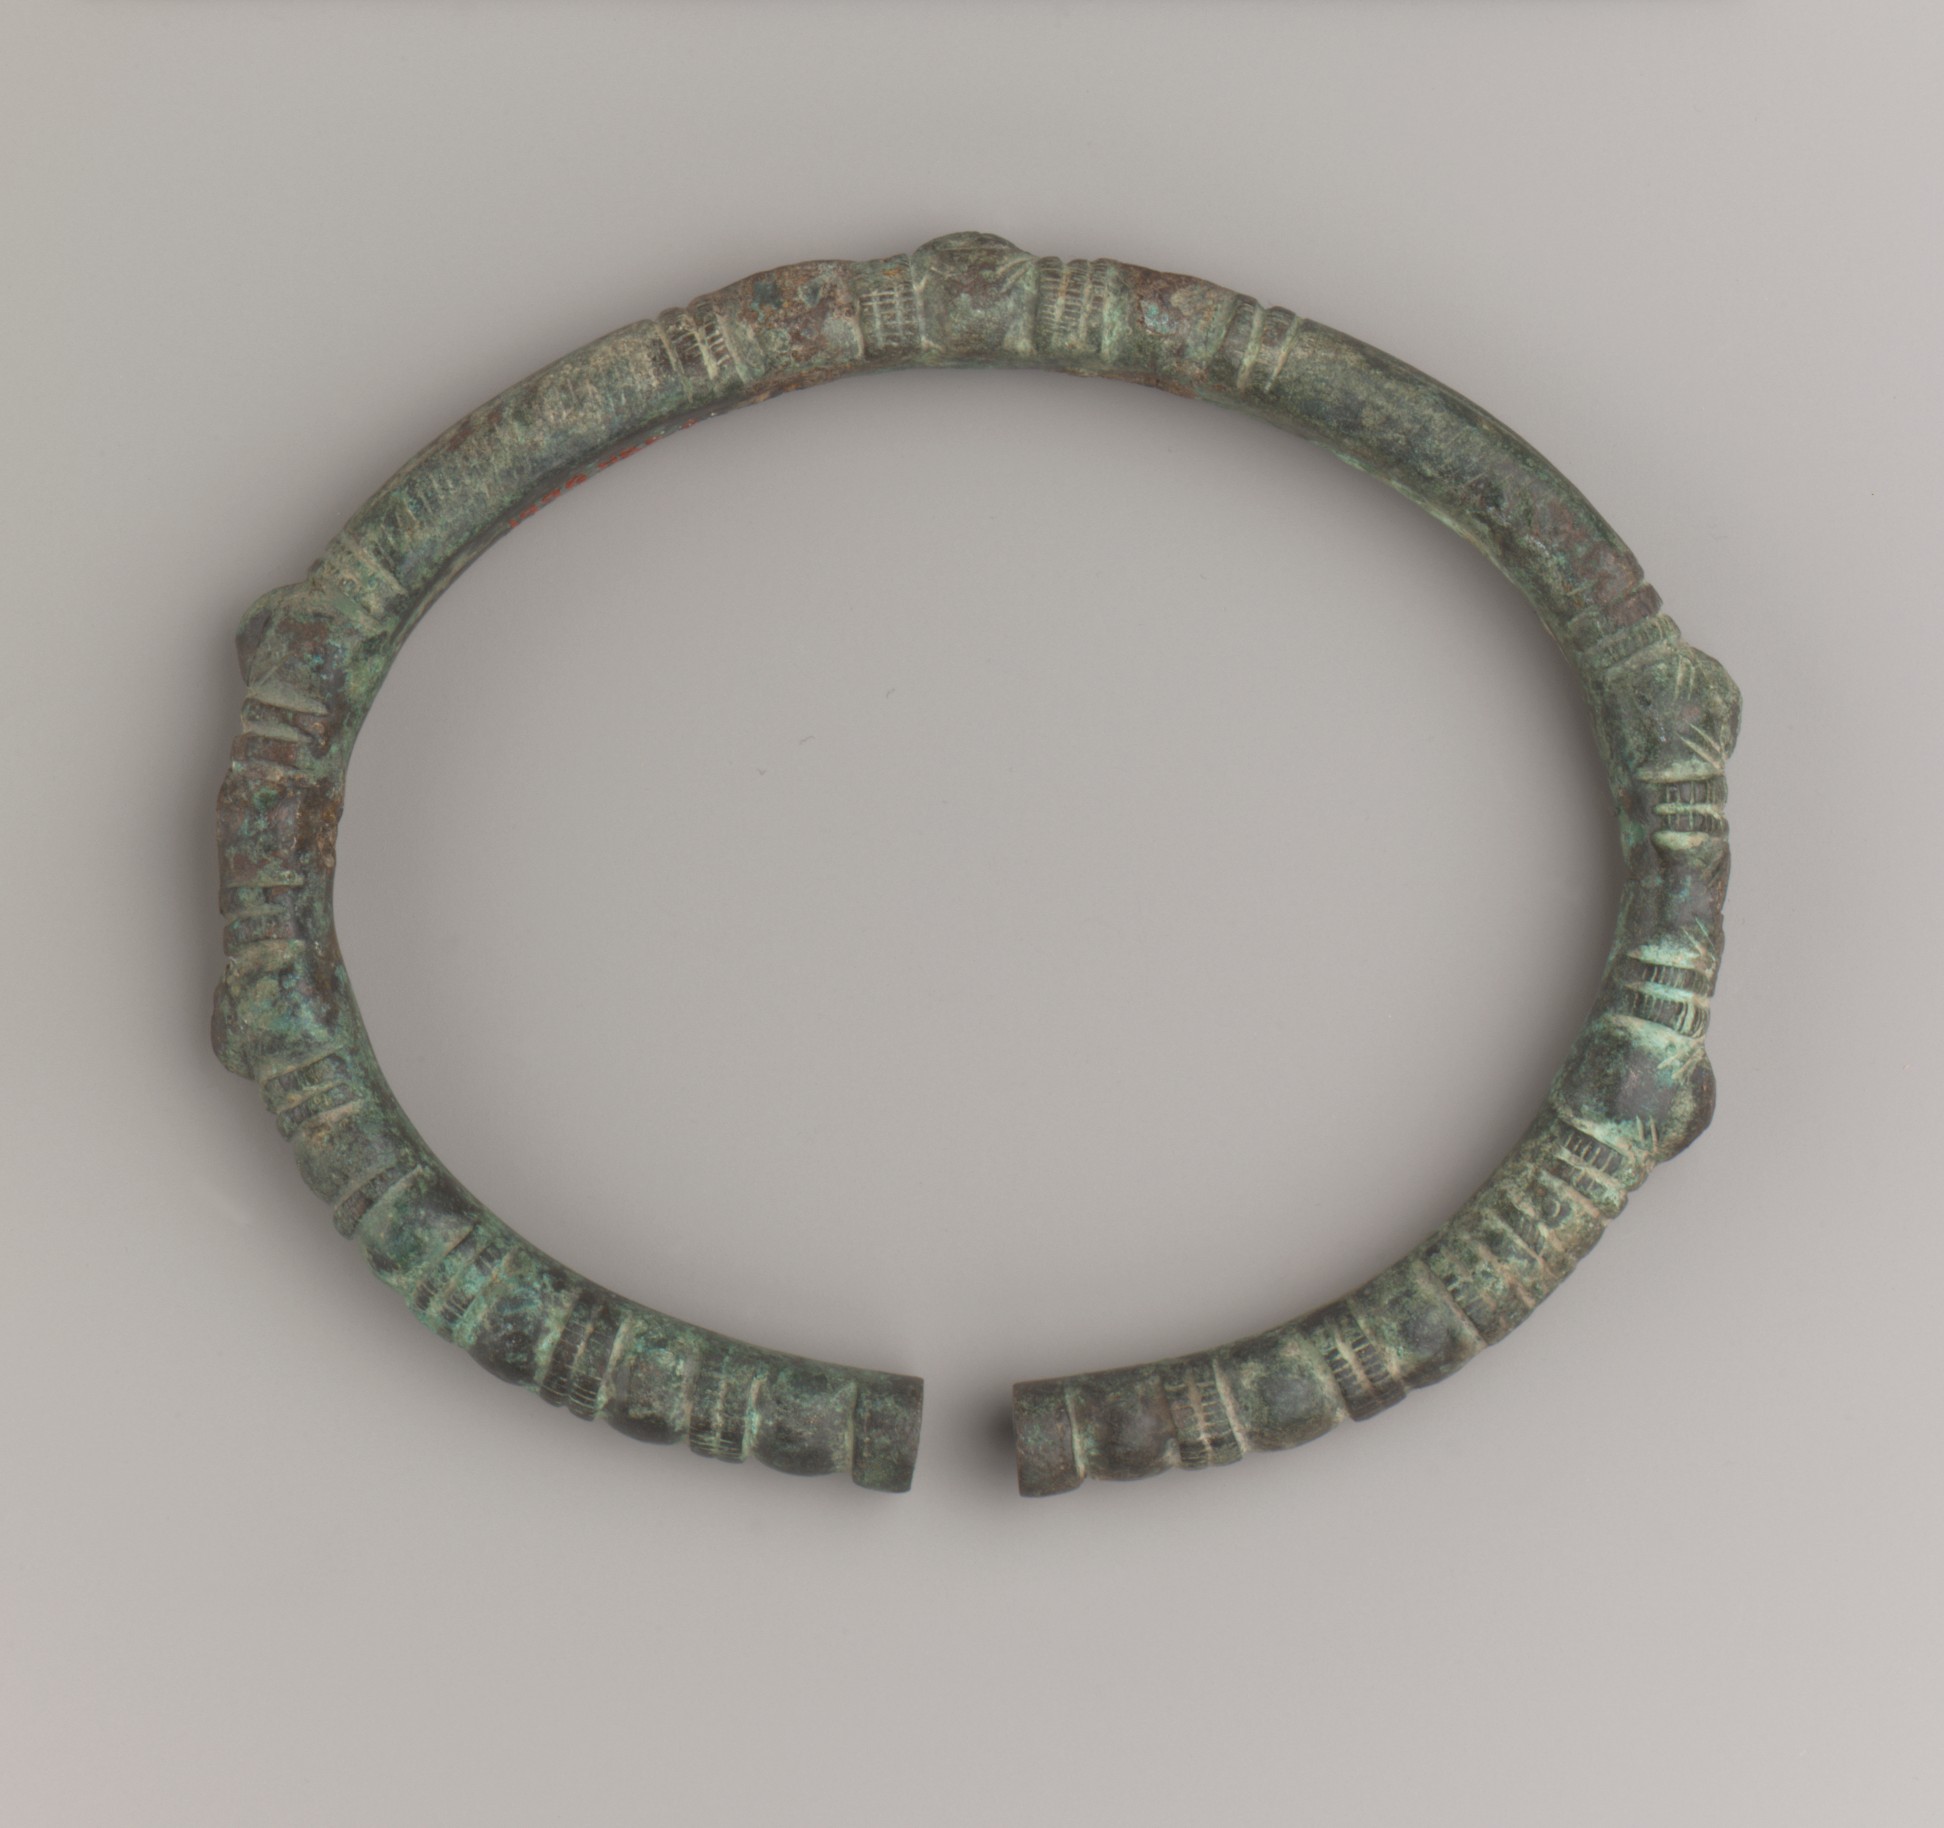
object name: bracelet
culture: middle niger civilization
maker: middle niger artist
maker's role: artist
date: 1001-1600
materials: copper alloy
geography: mali